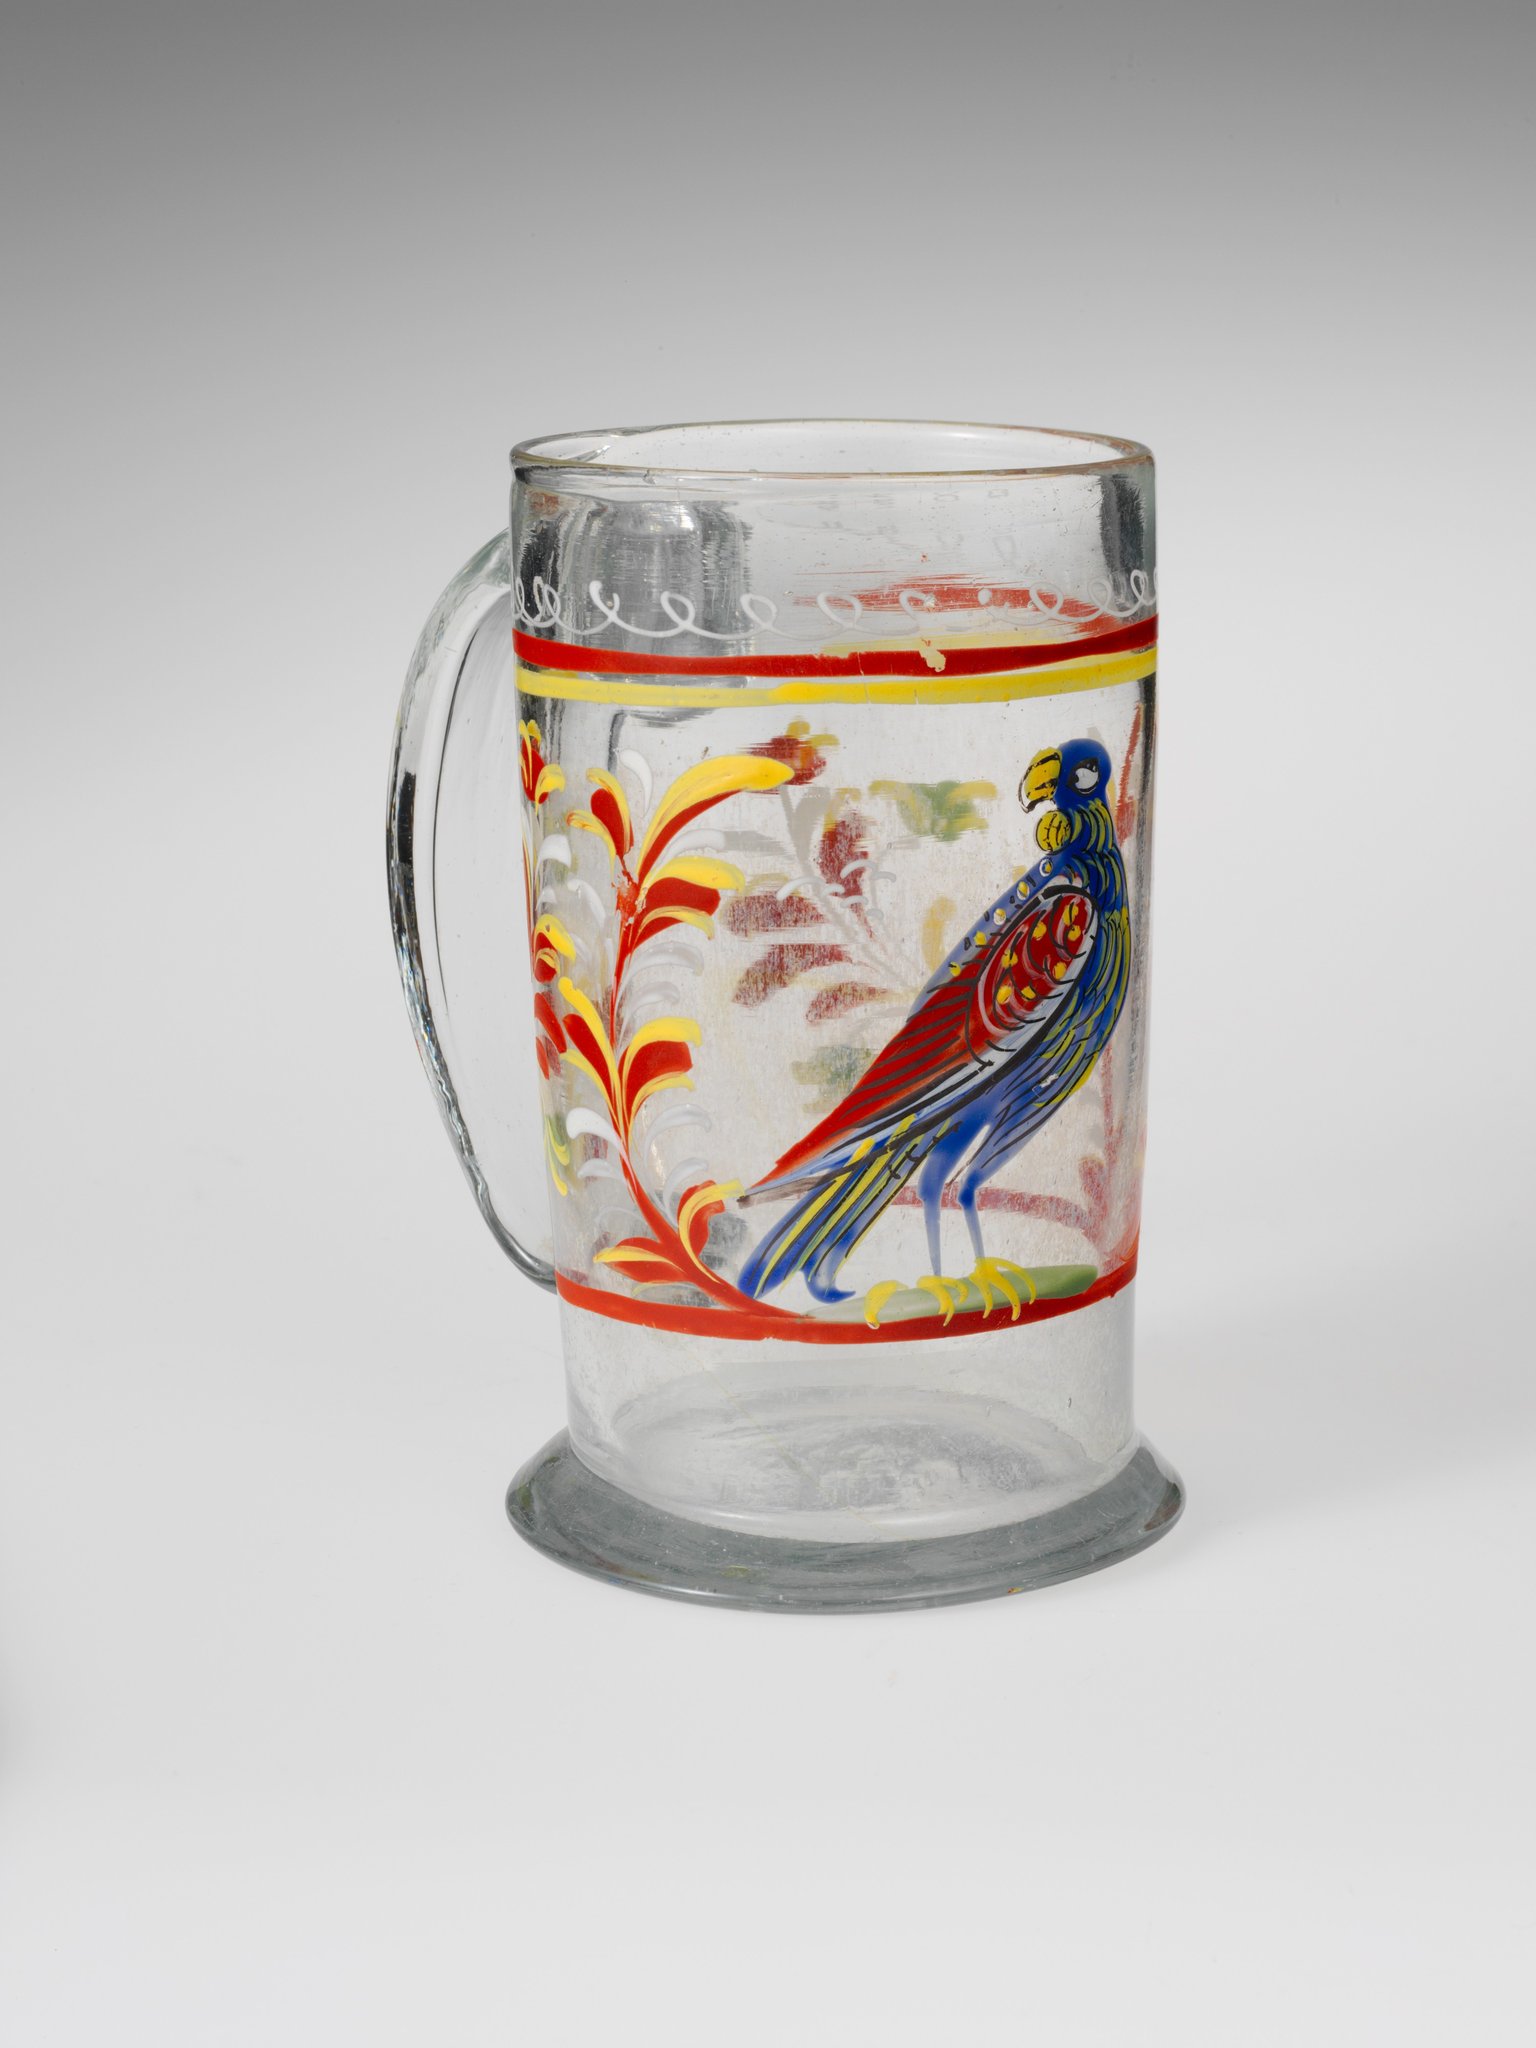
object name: mug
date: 1701-1800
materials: enamel, glass, lead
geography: czech republic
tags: birds